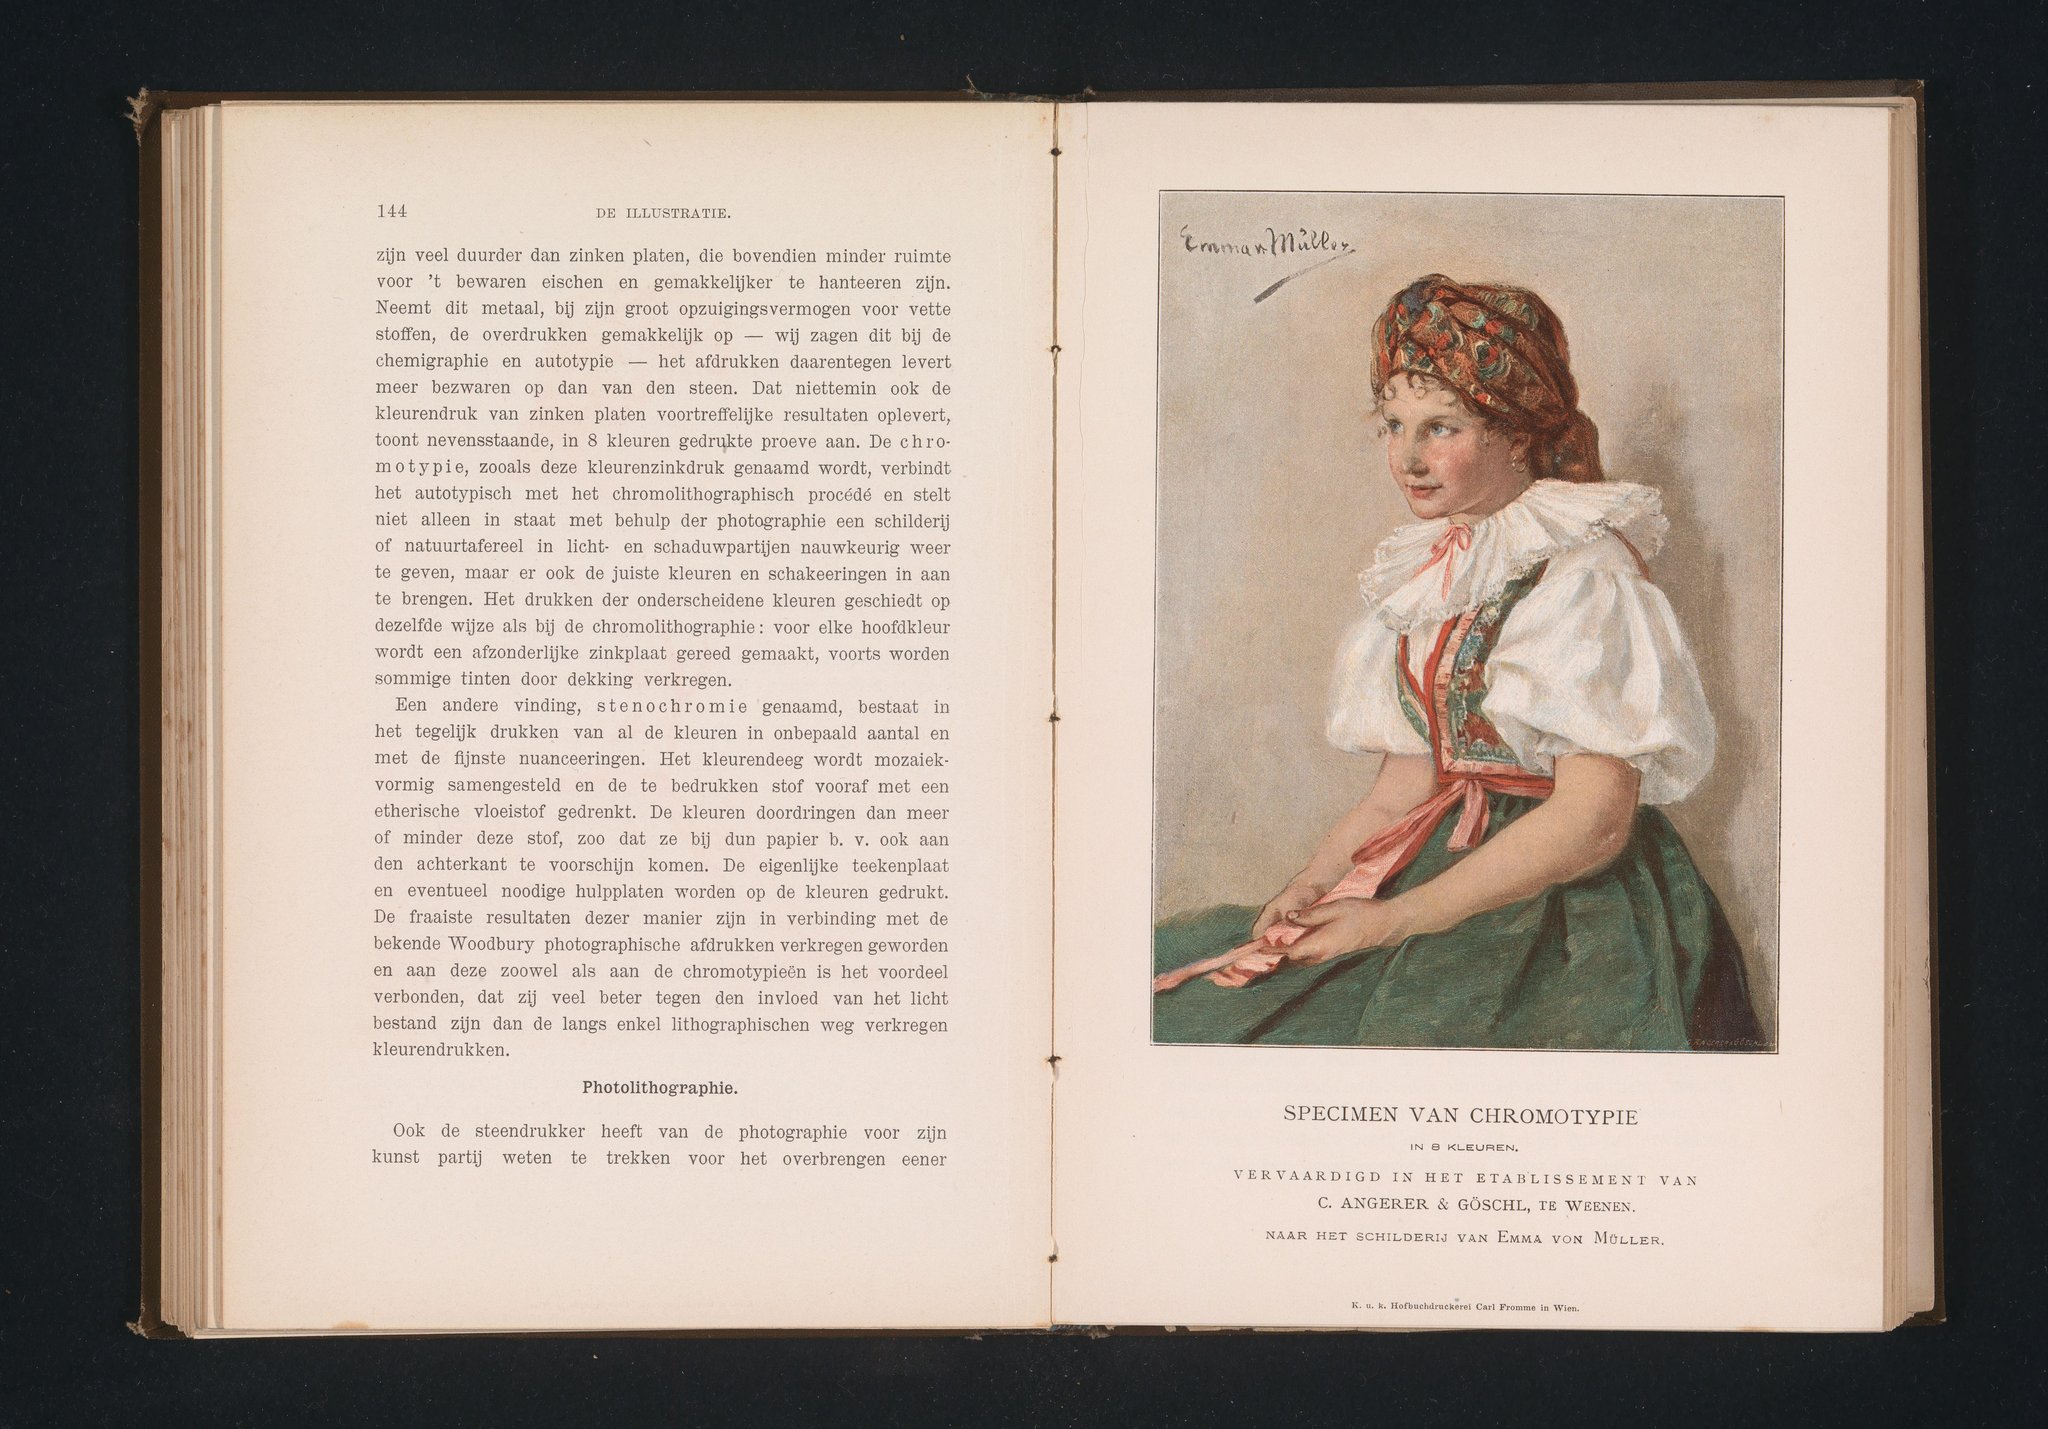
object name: photomechanical print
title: Specimen van Chromotypie/ in 8 kleuren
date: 1887-1892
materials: paper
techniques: four-color autotype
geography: vienna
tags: historical persons not known by name - bb - woman